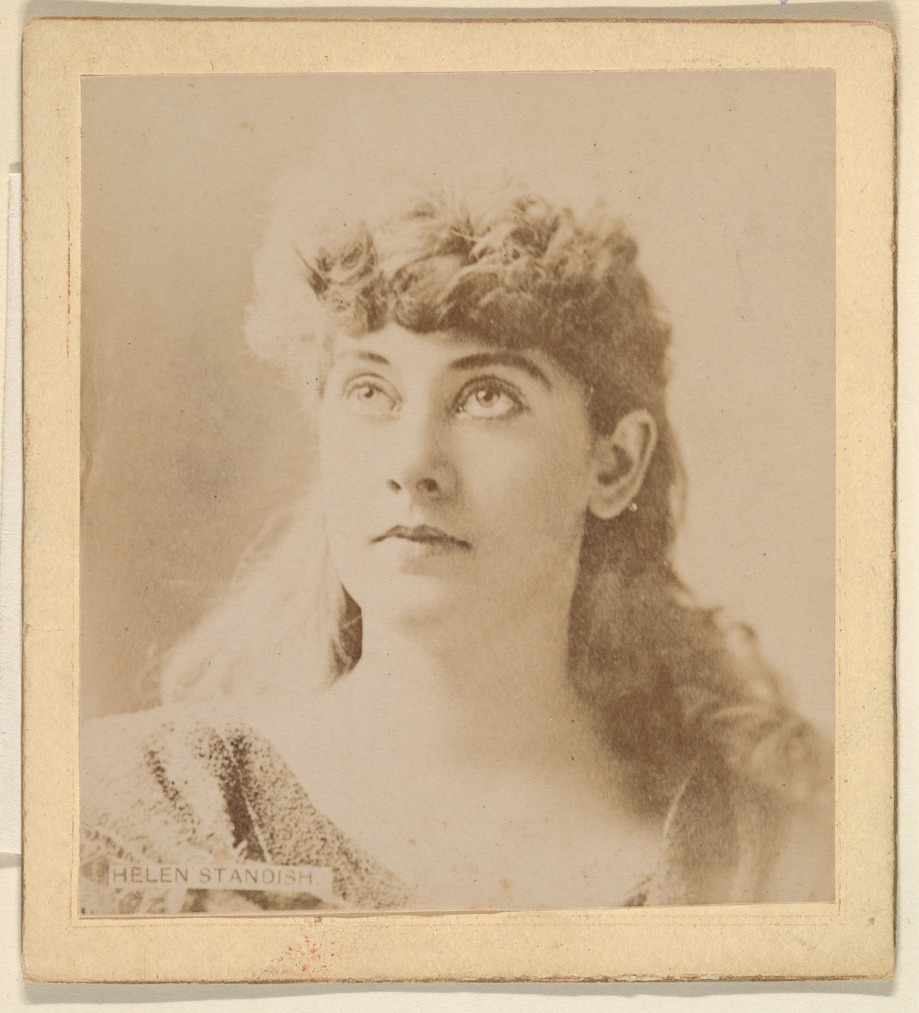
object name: photograph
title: Helen Standish, from the Actresses series (N246), Type 2, issued by Kinney Brothers to promote Sporting Extra Cigarettes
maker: kinney brothers tobacco company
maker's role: publisher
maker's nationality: american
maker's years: 1869-2011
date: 1890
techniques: albumen silver print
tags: portraits,women,actresses